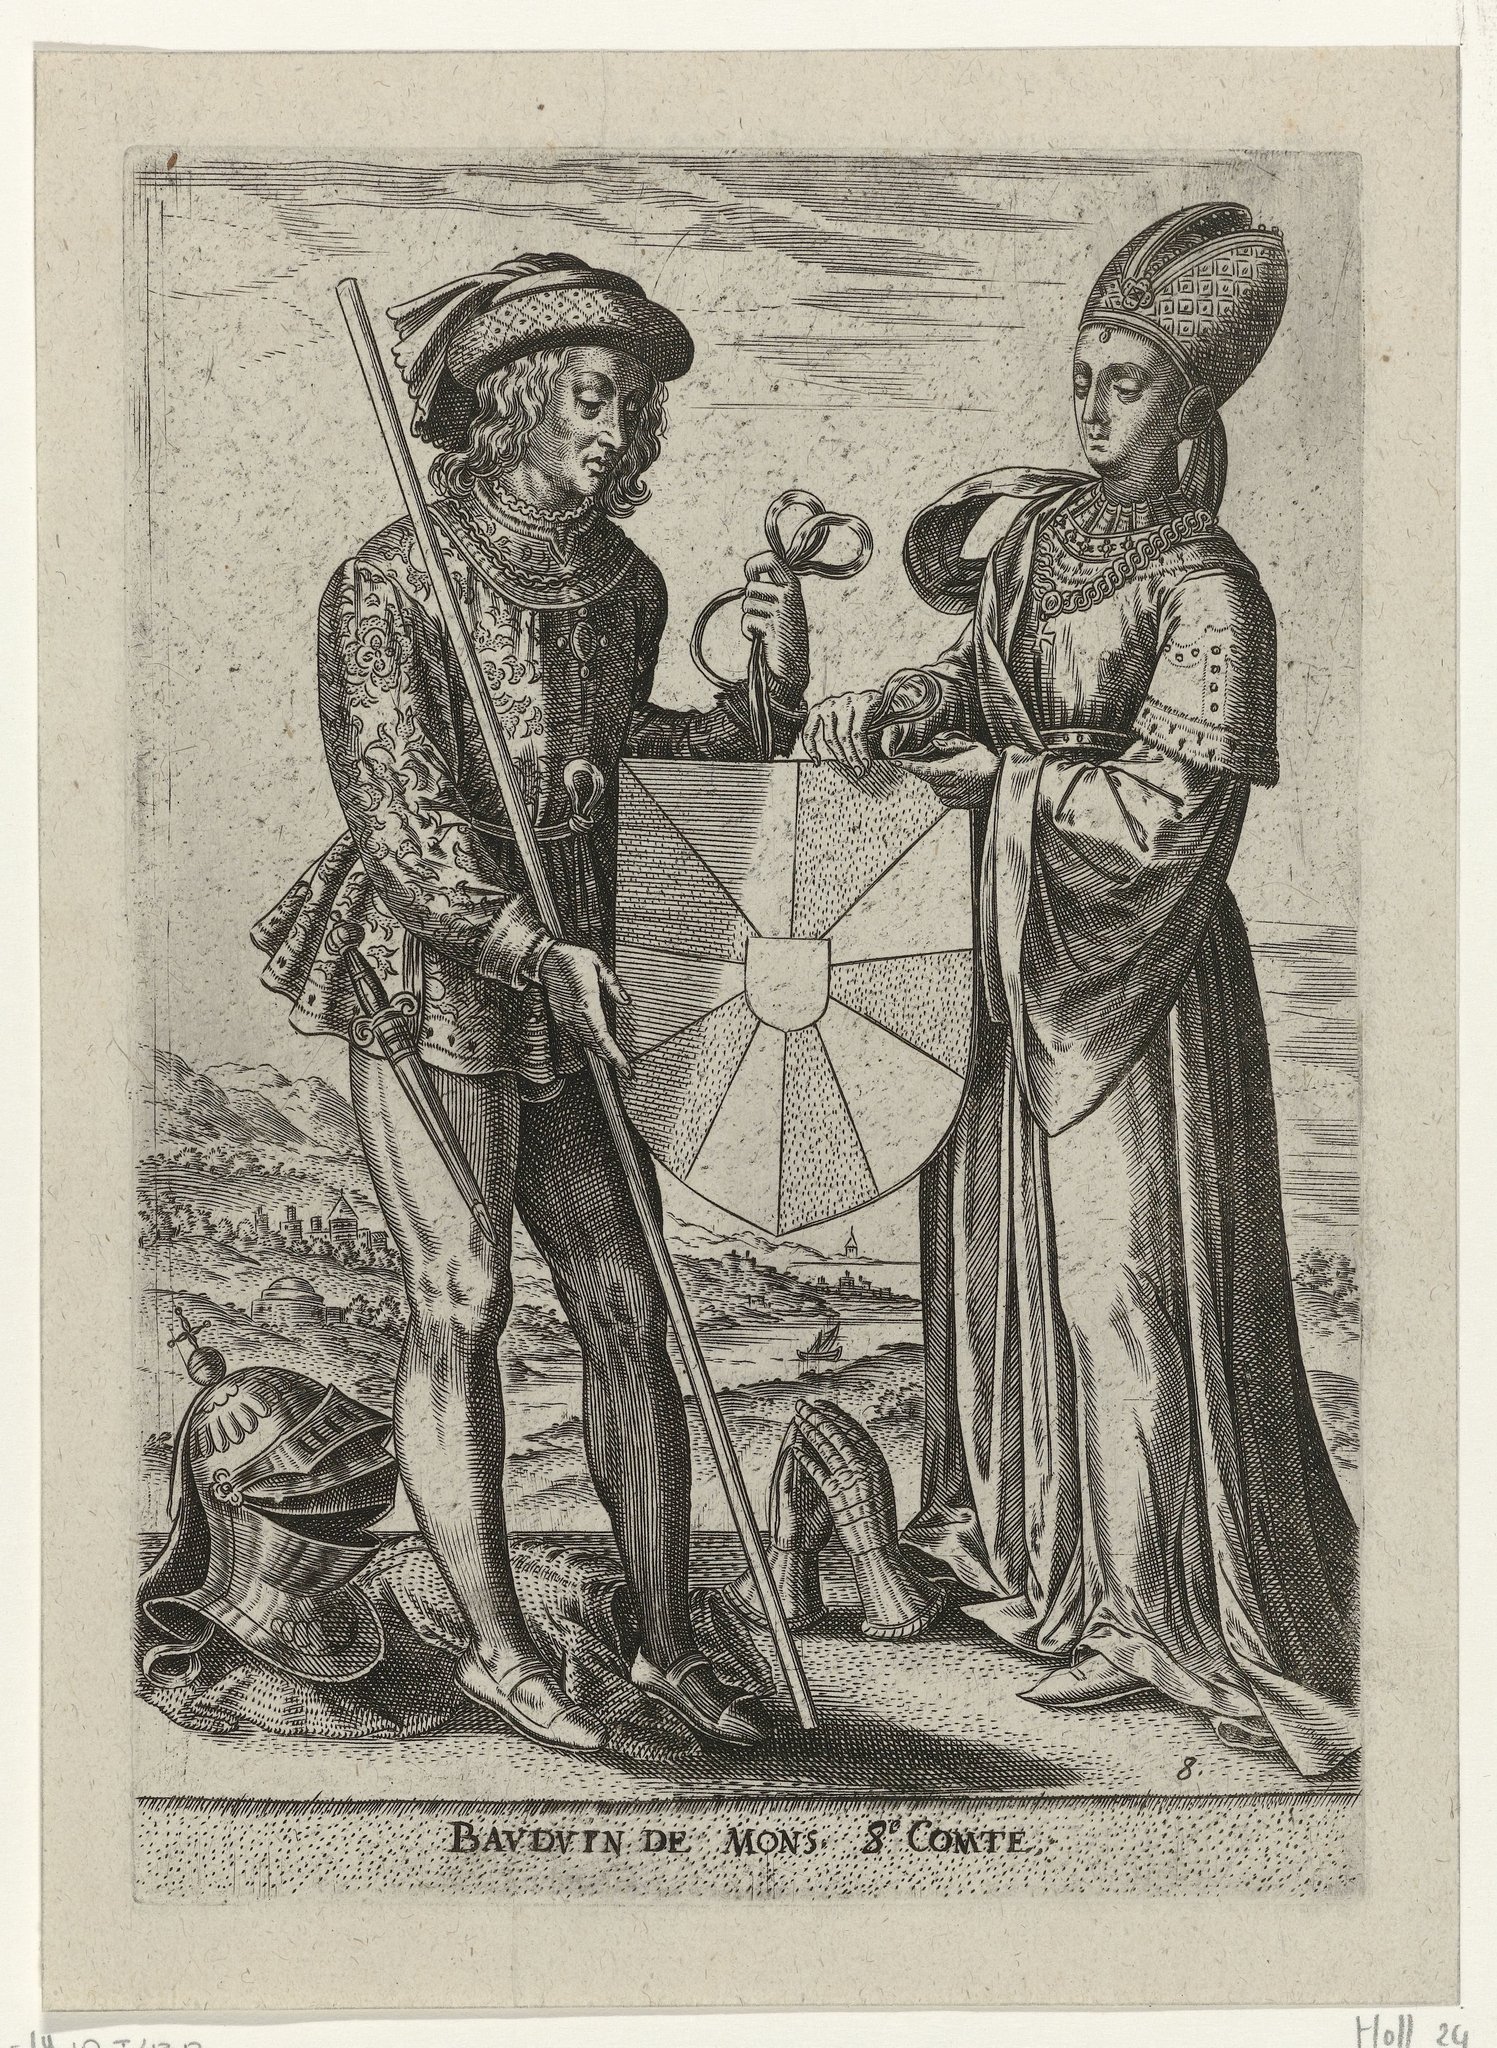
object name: print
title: Graven van Vlaanderen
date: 1584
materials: paper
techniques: engraving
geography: antwerp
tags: earl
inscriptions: collector's mark: Lugt 2228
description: Boudewijn, de zesde graaf van Vlaanderen, samen met zijn vrouw Richilde, de gravin van Henegouwen. Ze dragen het voormalige wapenschild van Vlaanderen. De prent dient als een illustratie bij een boek over de geschiedenis van de graven van Vlaanderen.